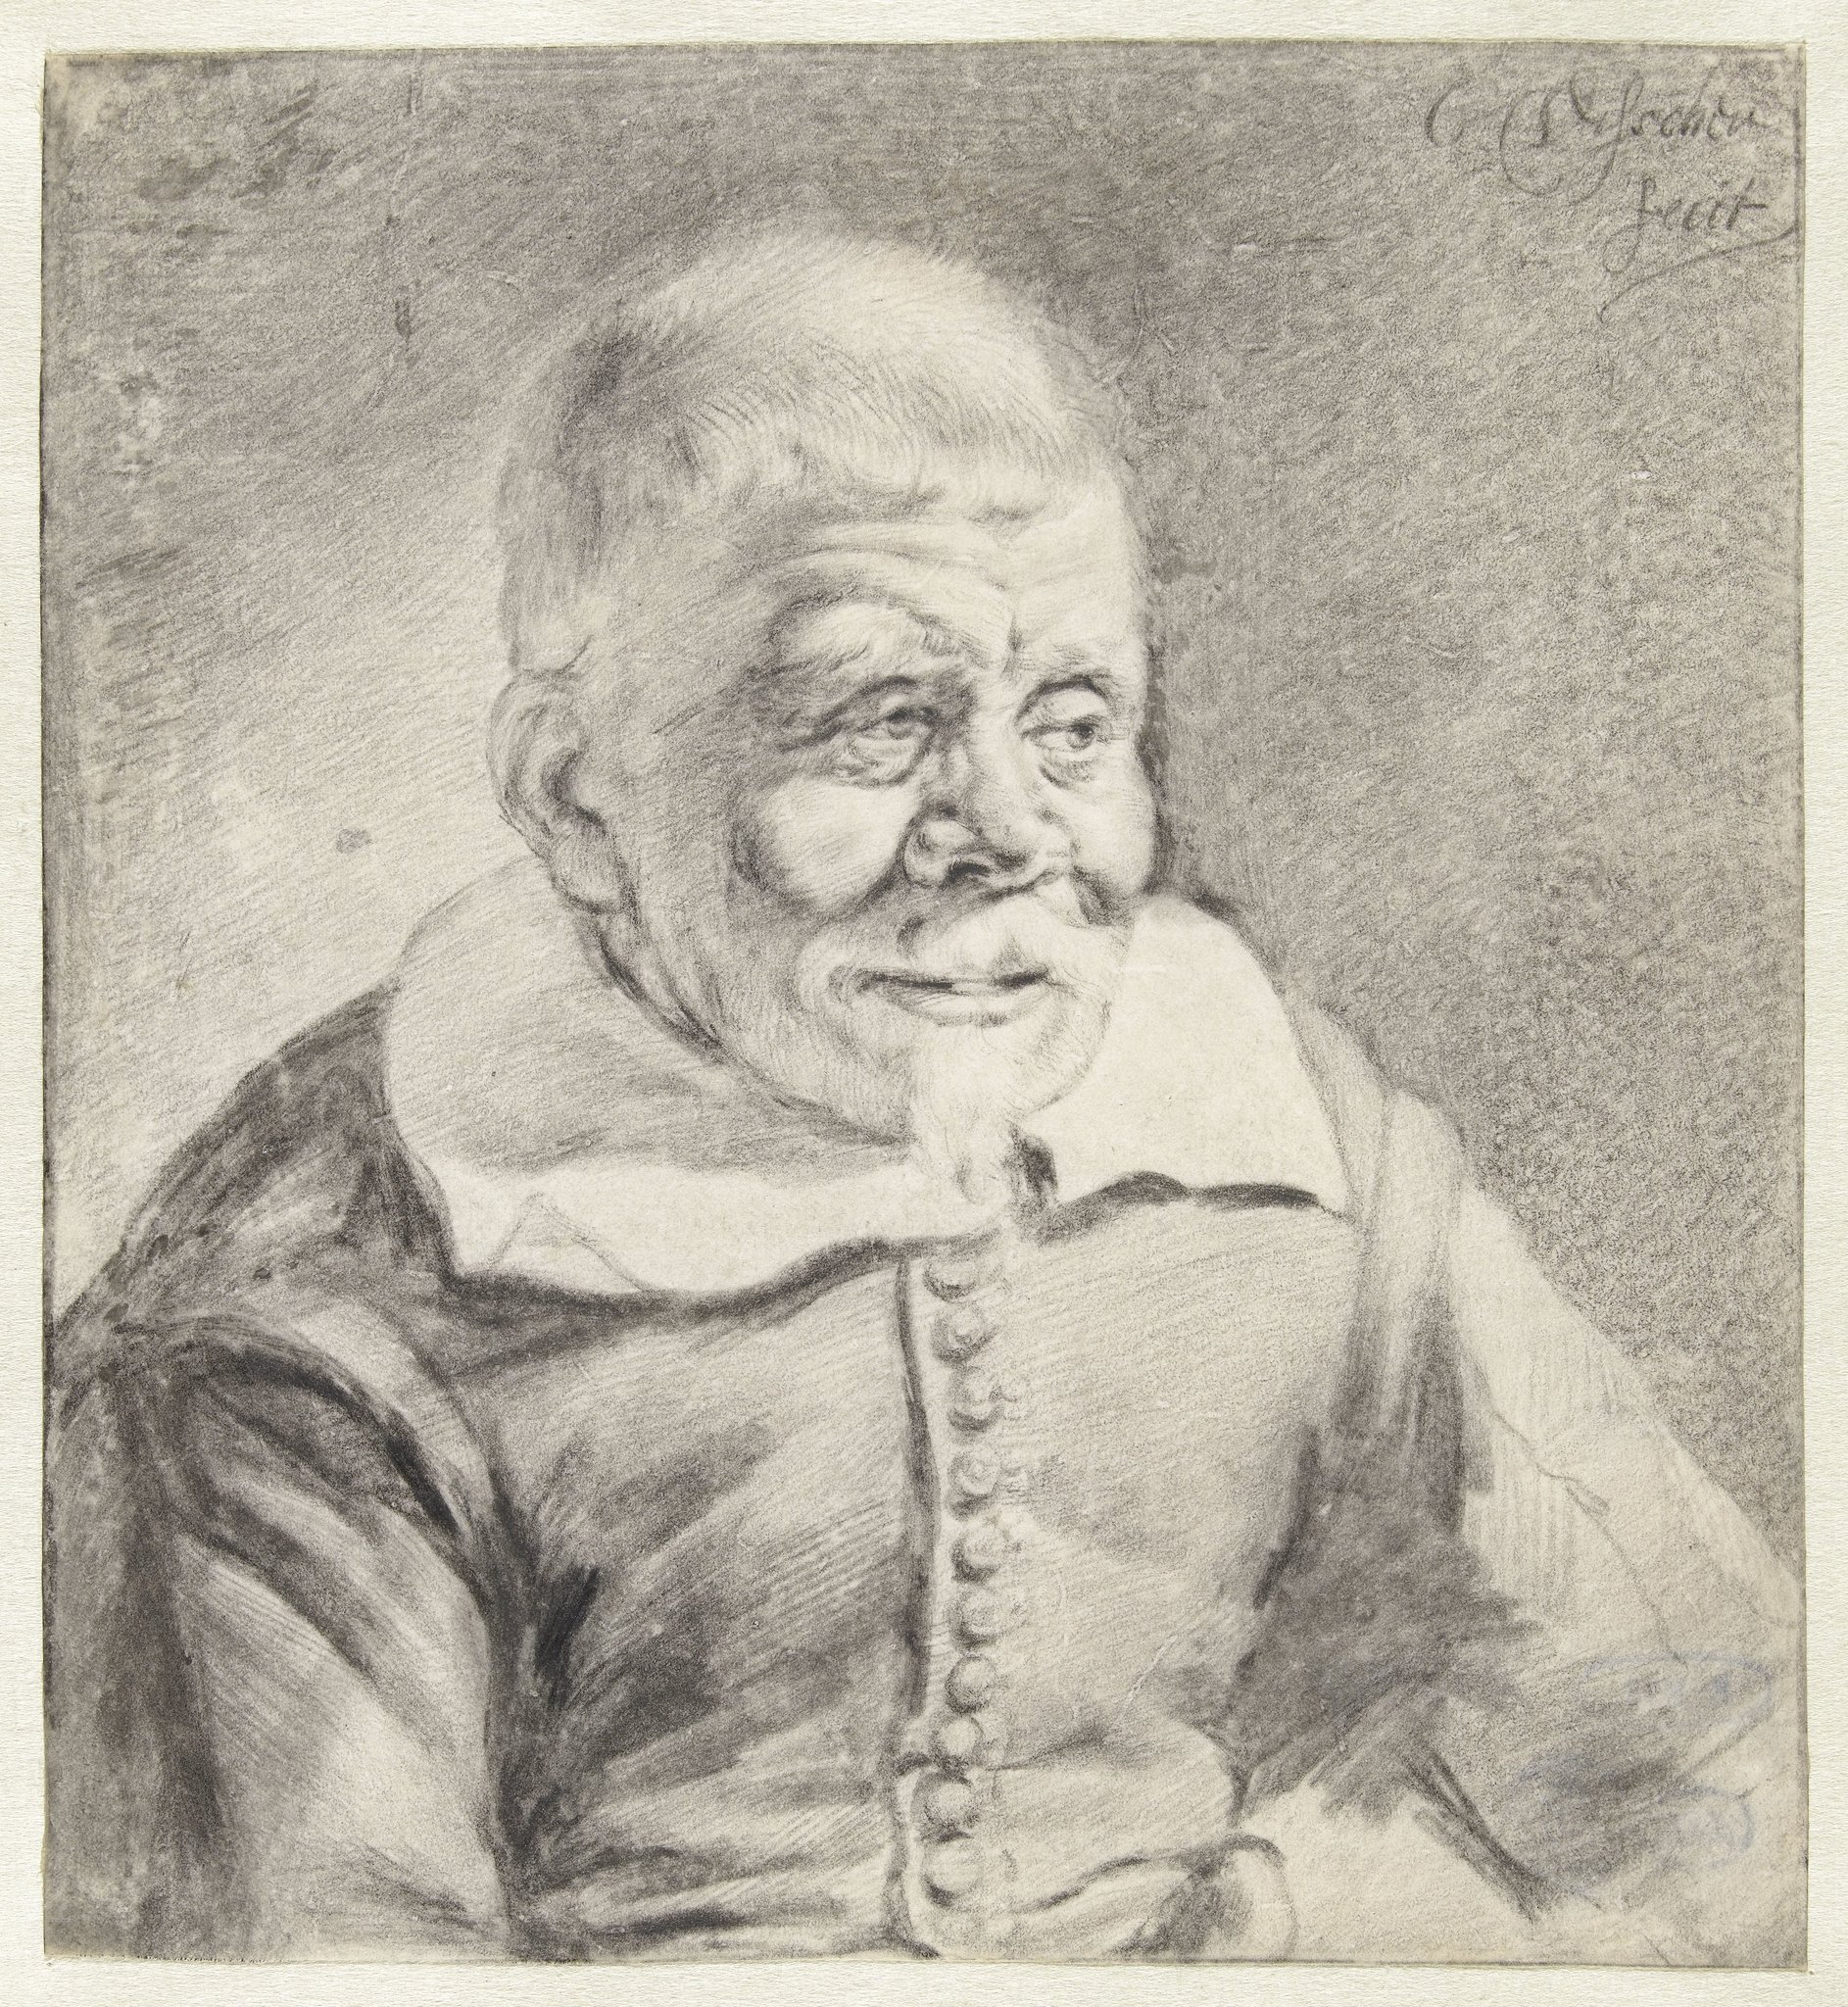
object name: drawing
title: Portrait of an Old Man, Seated Half Length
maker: cornelis visscher (ii)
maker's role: draughtsman, painter, print maker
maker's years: 1628-1658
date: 1654-1658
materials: chalk, parchment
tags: old man